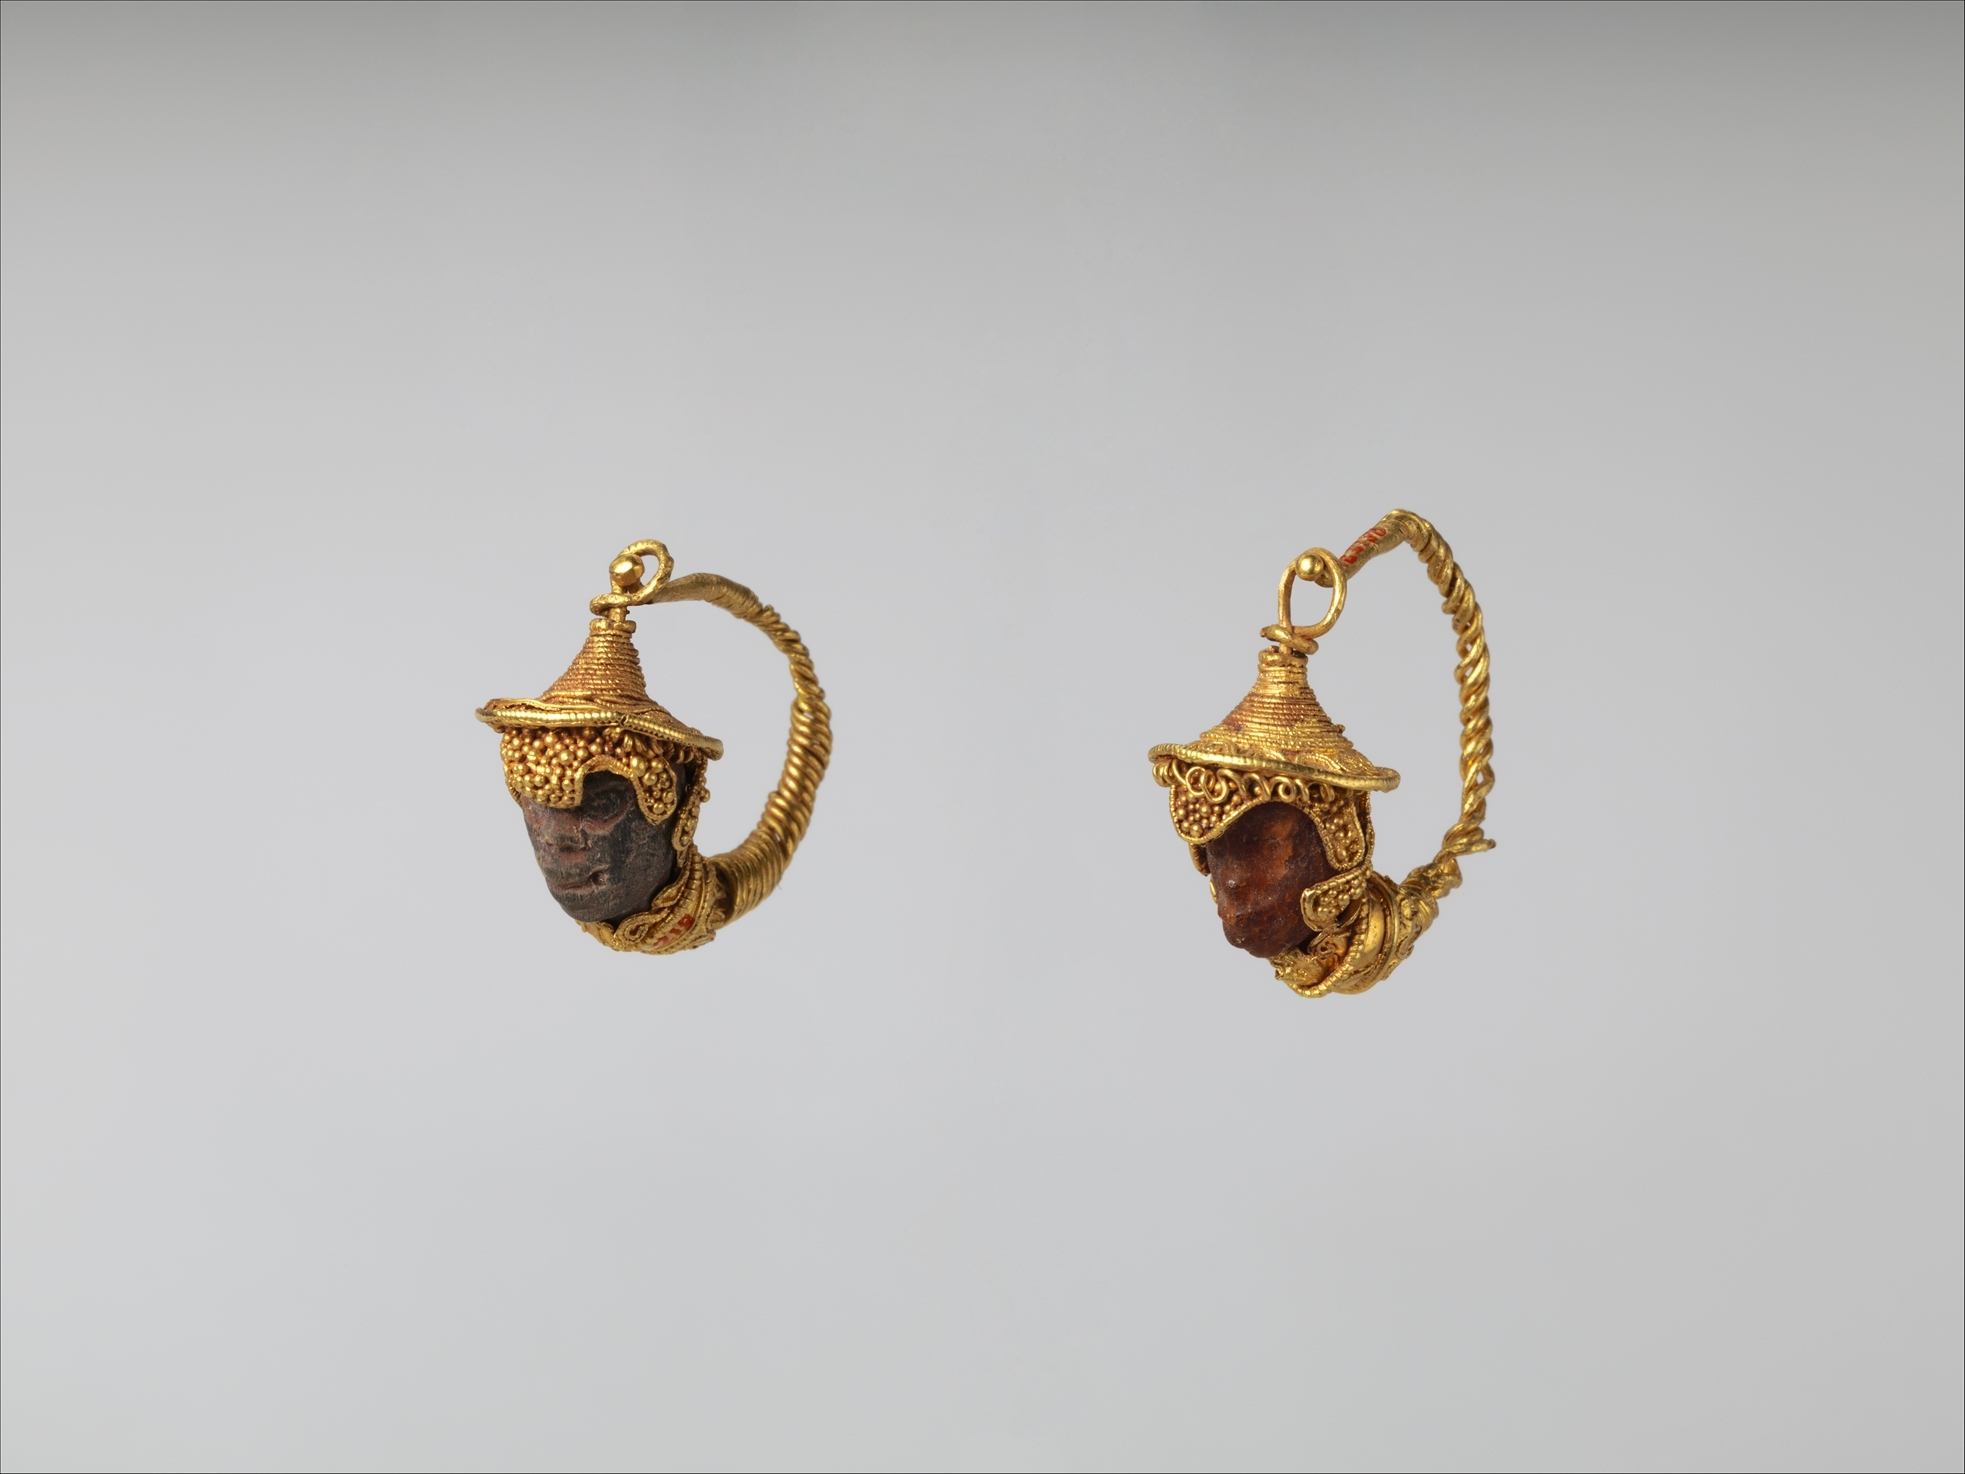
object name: earring with head of a black youth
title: Gold and amber earrings with head of a Black African youth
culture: etruscan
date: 200-100 BCE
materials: amber, gold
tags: heads